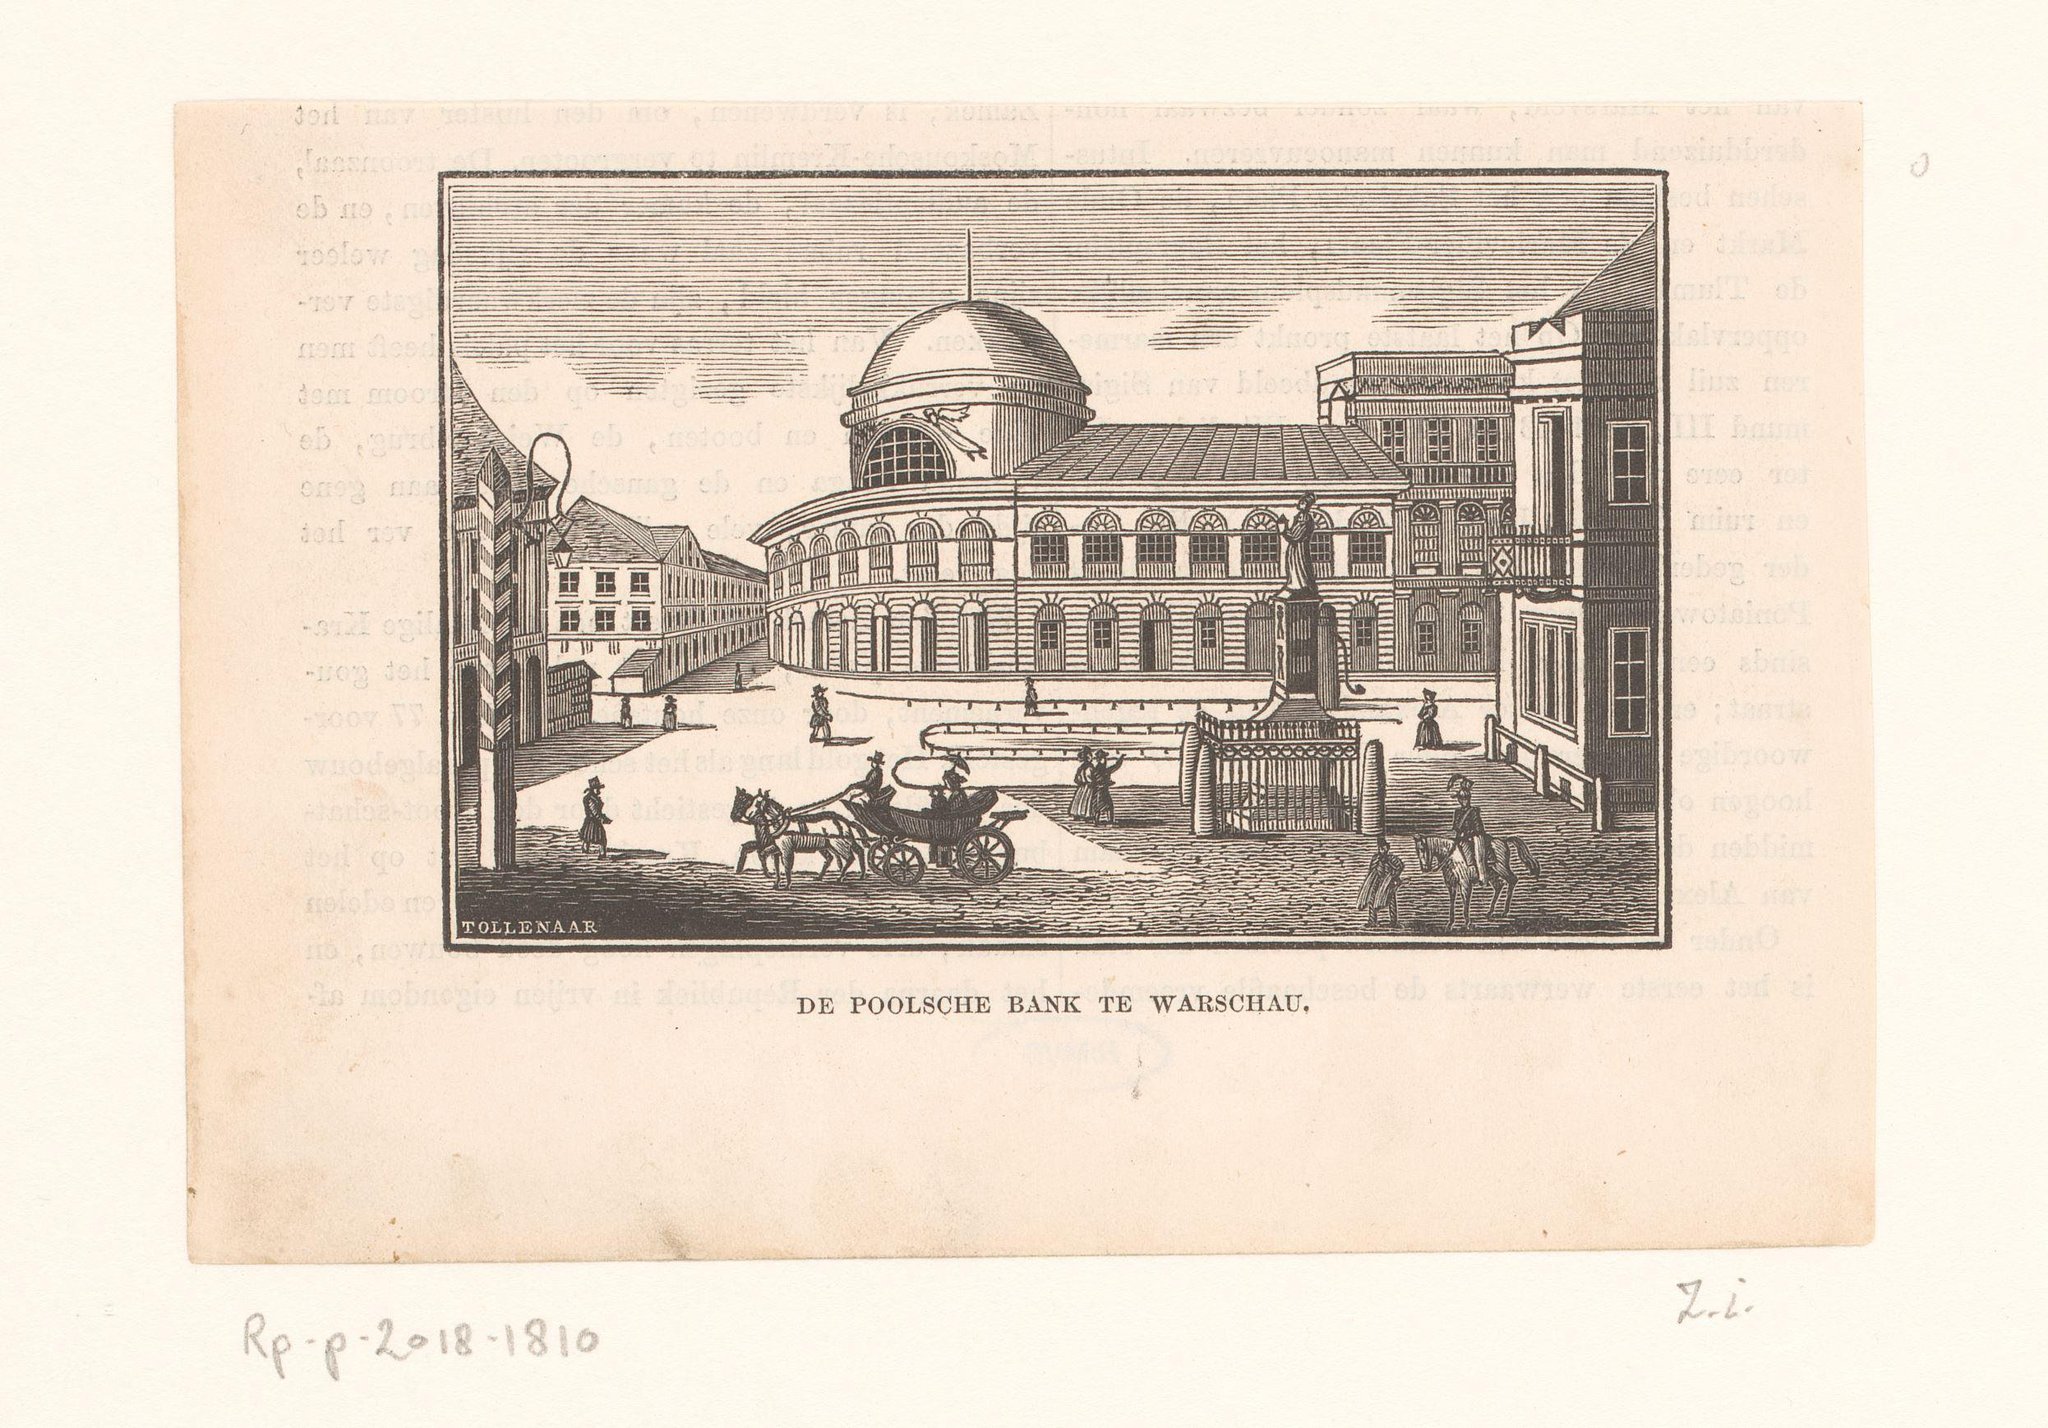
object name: print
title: Gezicht op het bankgebouw, te Warschau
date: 1847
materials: paper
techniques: letterpress printing, engraving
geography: amsterdam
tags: bank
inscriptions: collector's mark: Lugt 2228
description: Prent gebruikt in: Witkamp, P.H. Beschrijving van Oost- en Noord-Europa. Amsterdam: J.H. Laarman, 1847.